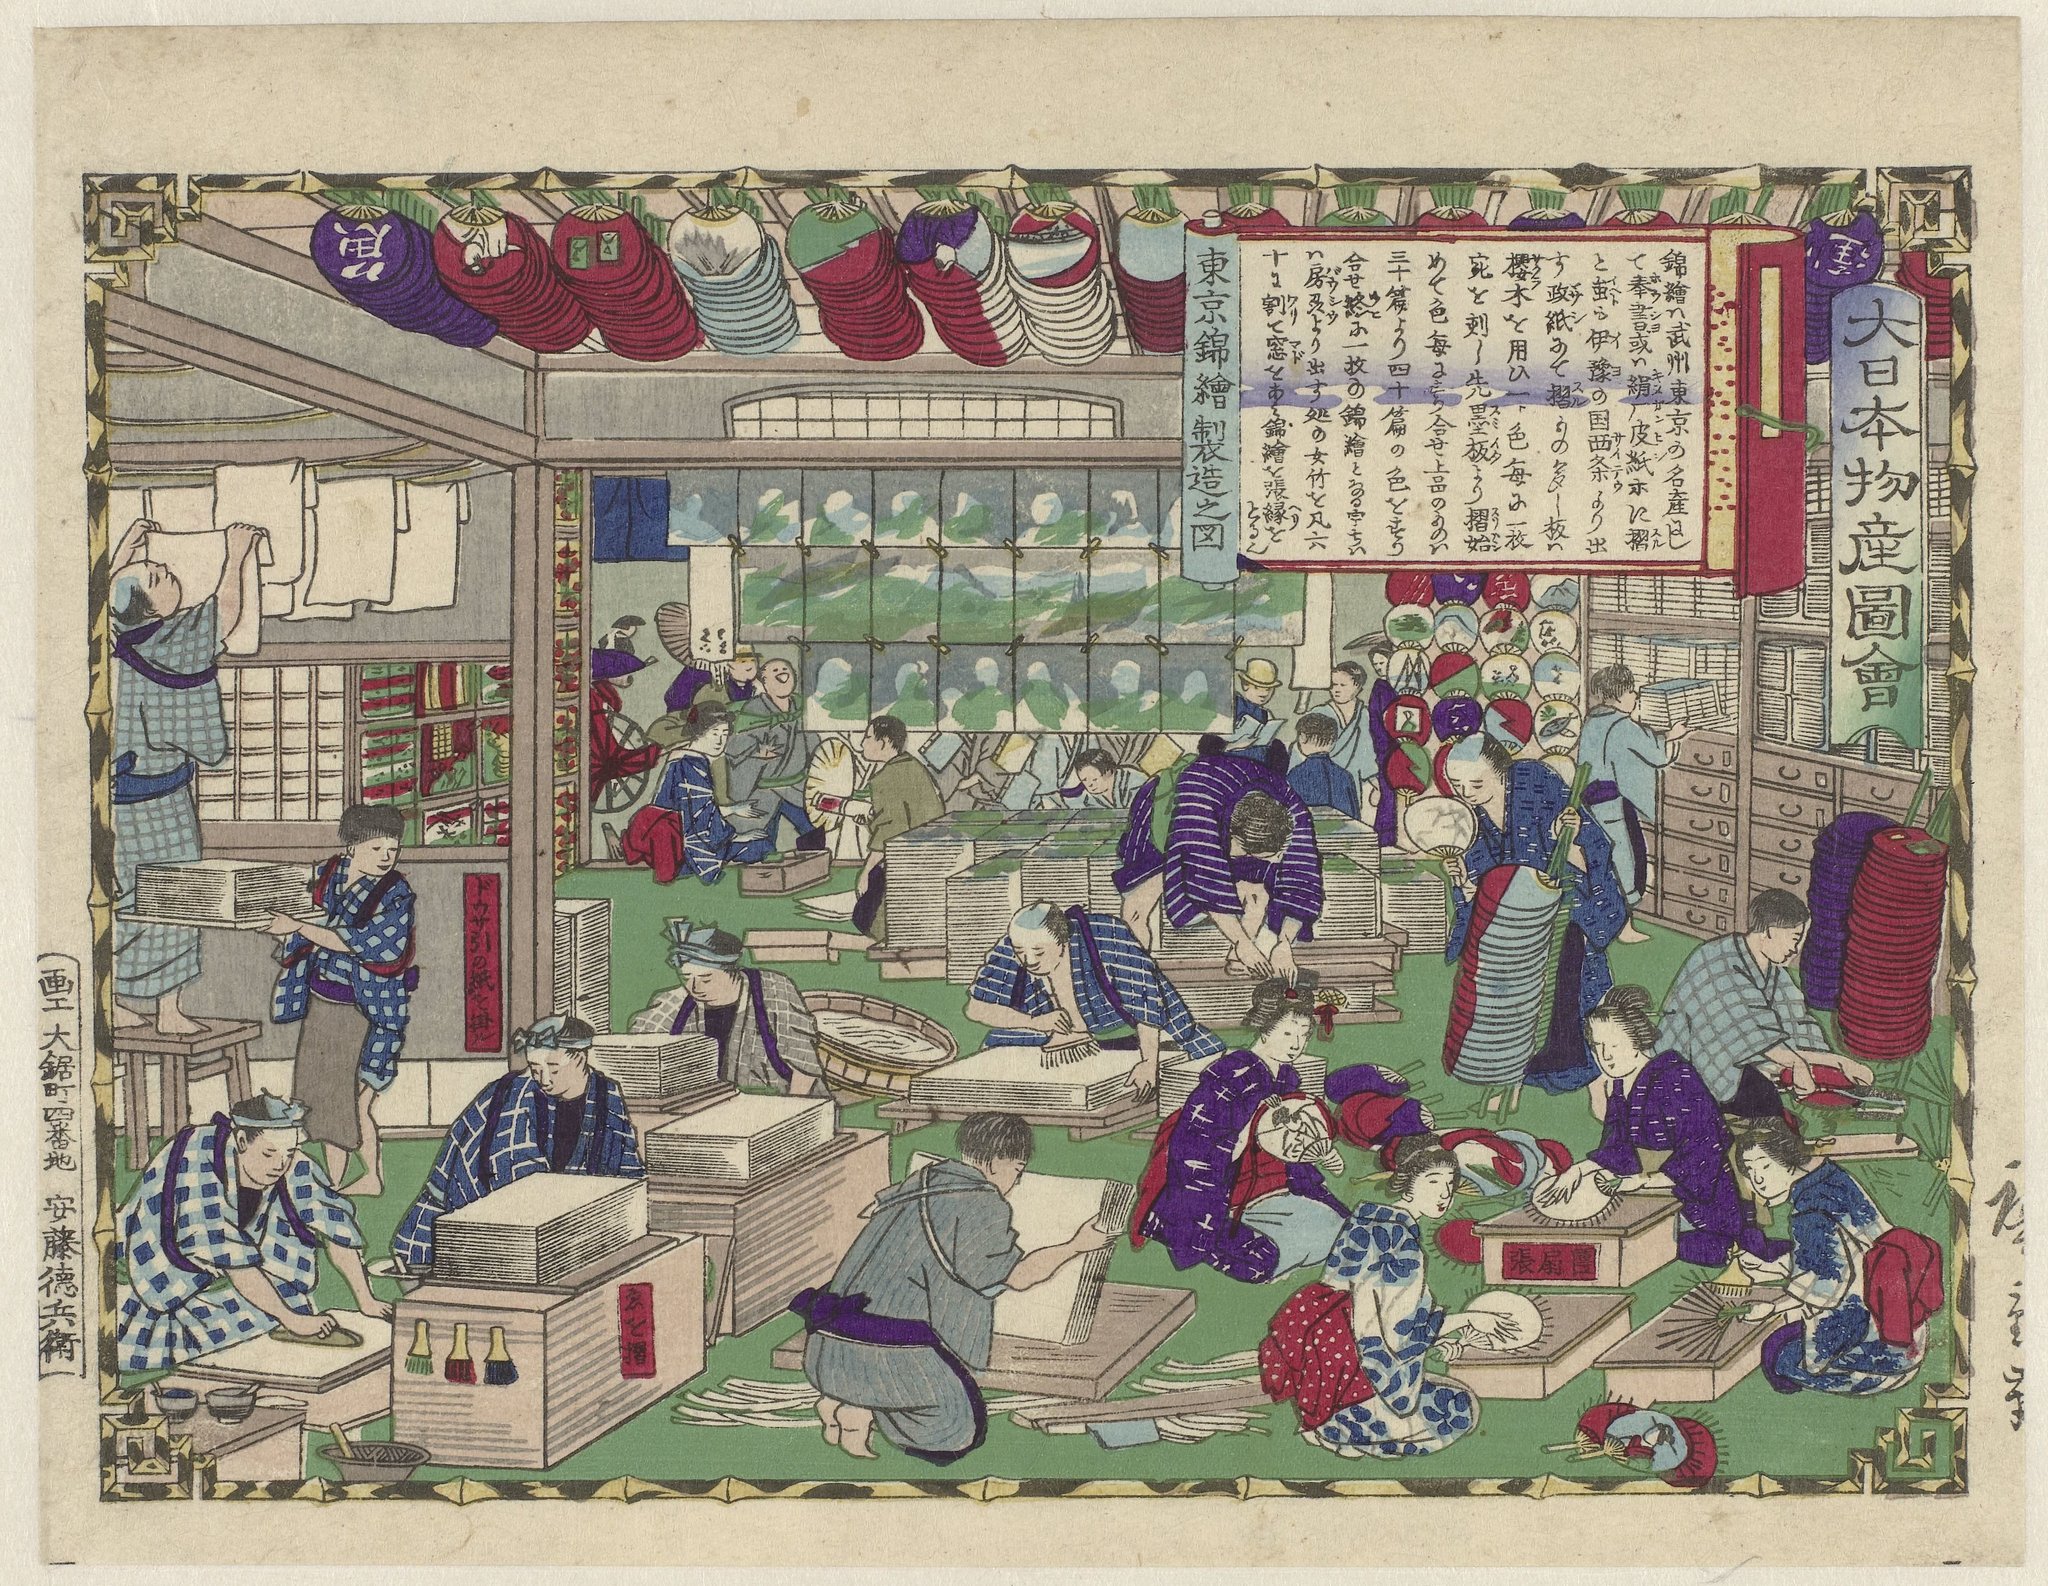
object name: print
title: Een voorstelling van de productie van waaiers in Tokyo (''Tokyo nishiki-e seizo no zu'')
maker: utagawa hiroshige (iii)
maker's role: print maker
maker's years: 1842-1894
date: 1877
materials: paper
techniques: woodcut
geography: tokyo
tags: craft-production, skilled handiwork, fan, workshop-interior